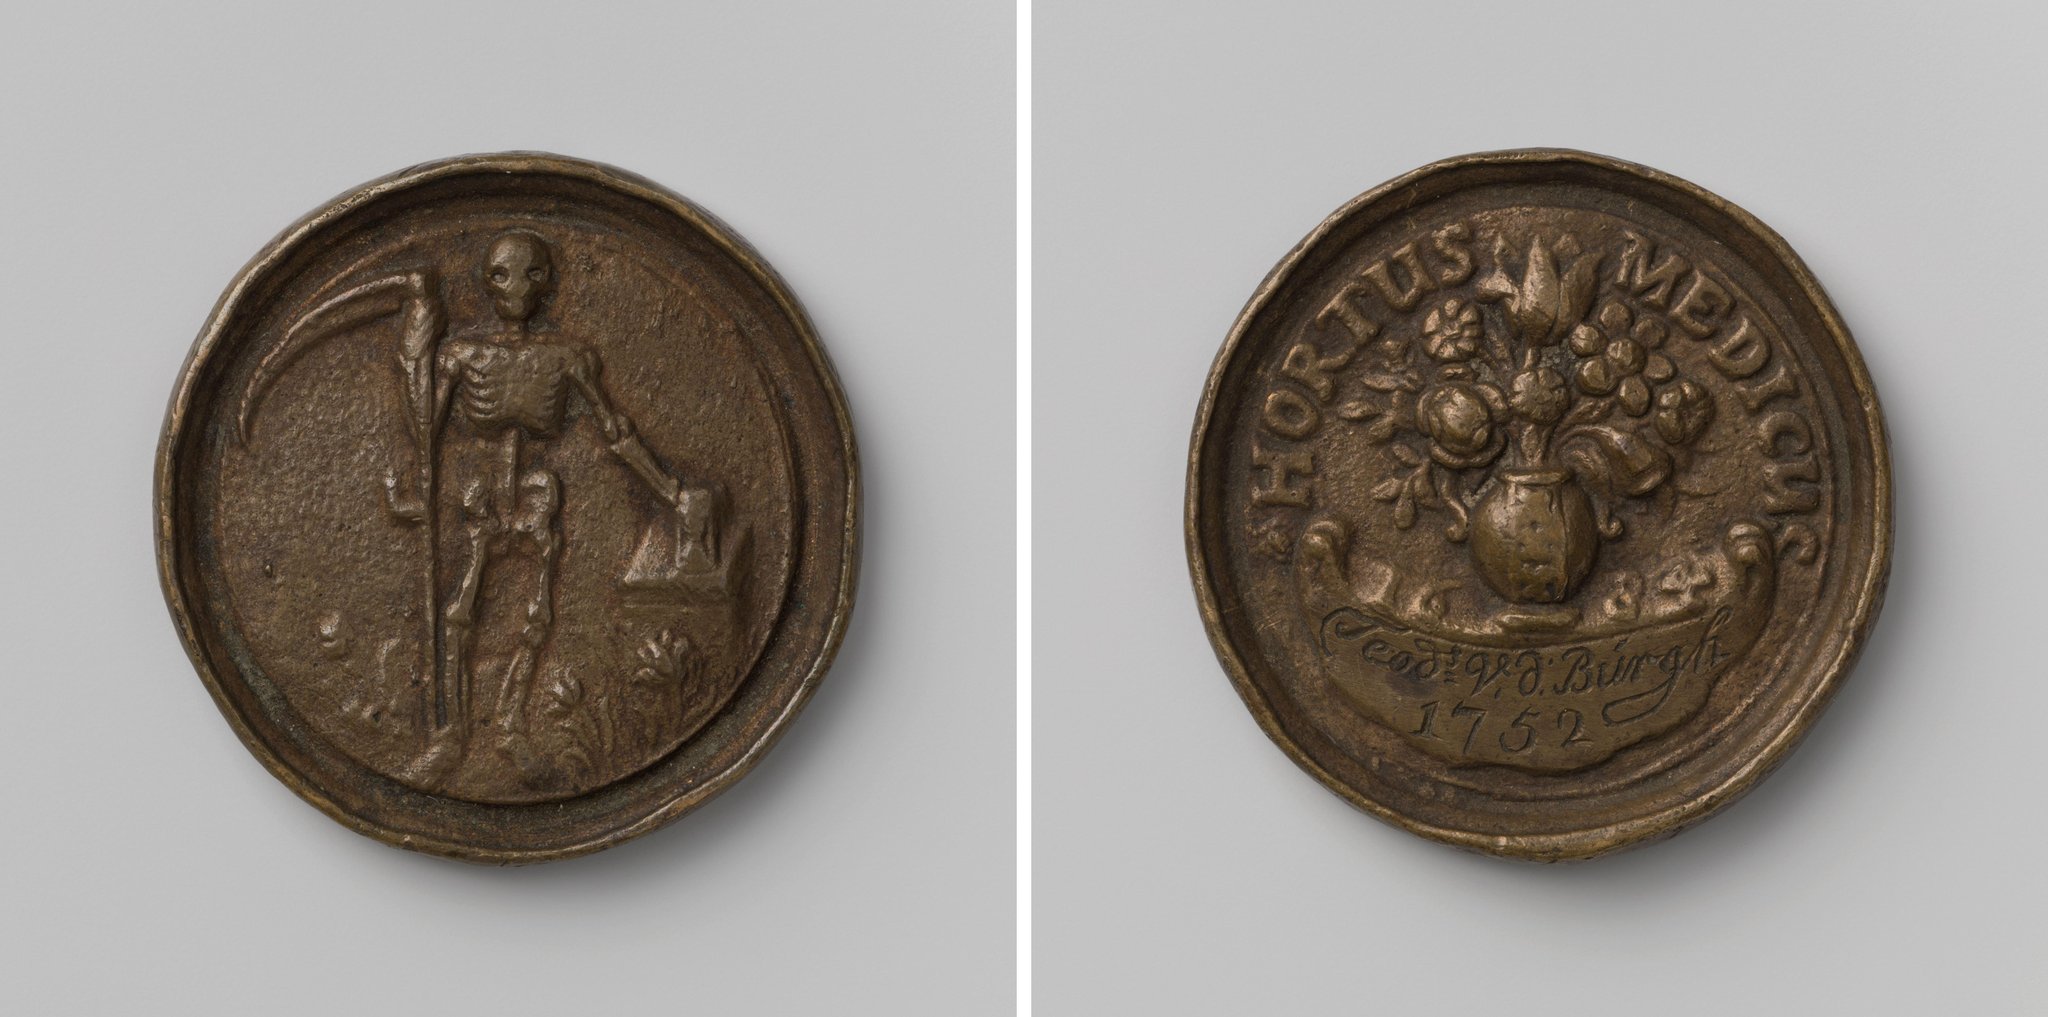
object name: toegangspenning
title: Chirurgijnsgilde te Amsterdam, toegangspenning voor de hortus medicus van Theod.s van den Burgh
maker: Anonymous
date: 1752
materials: brass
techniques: casting, engraving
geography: amsterdam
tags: amsterdam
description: Messing penning. Voorzijde: Dood, afgebeeld als geraamte, in bloemenveld met zeis in rechterhand en met linkerhand op zandloper, die op sokkel staat. Keerzijde: vaas met bloemen tussen jaartal; op vaas: wapenschild boven cartouche binnen omschrift